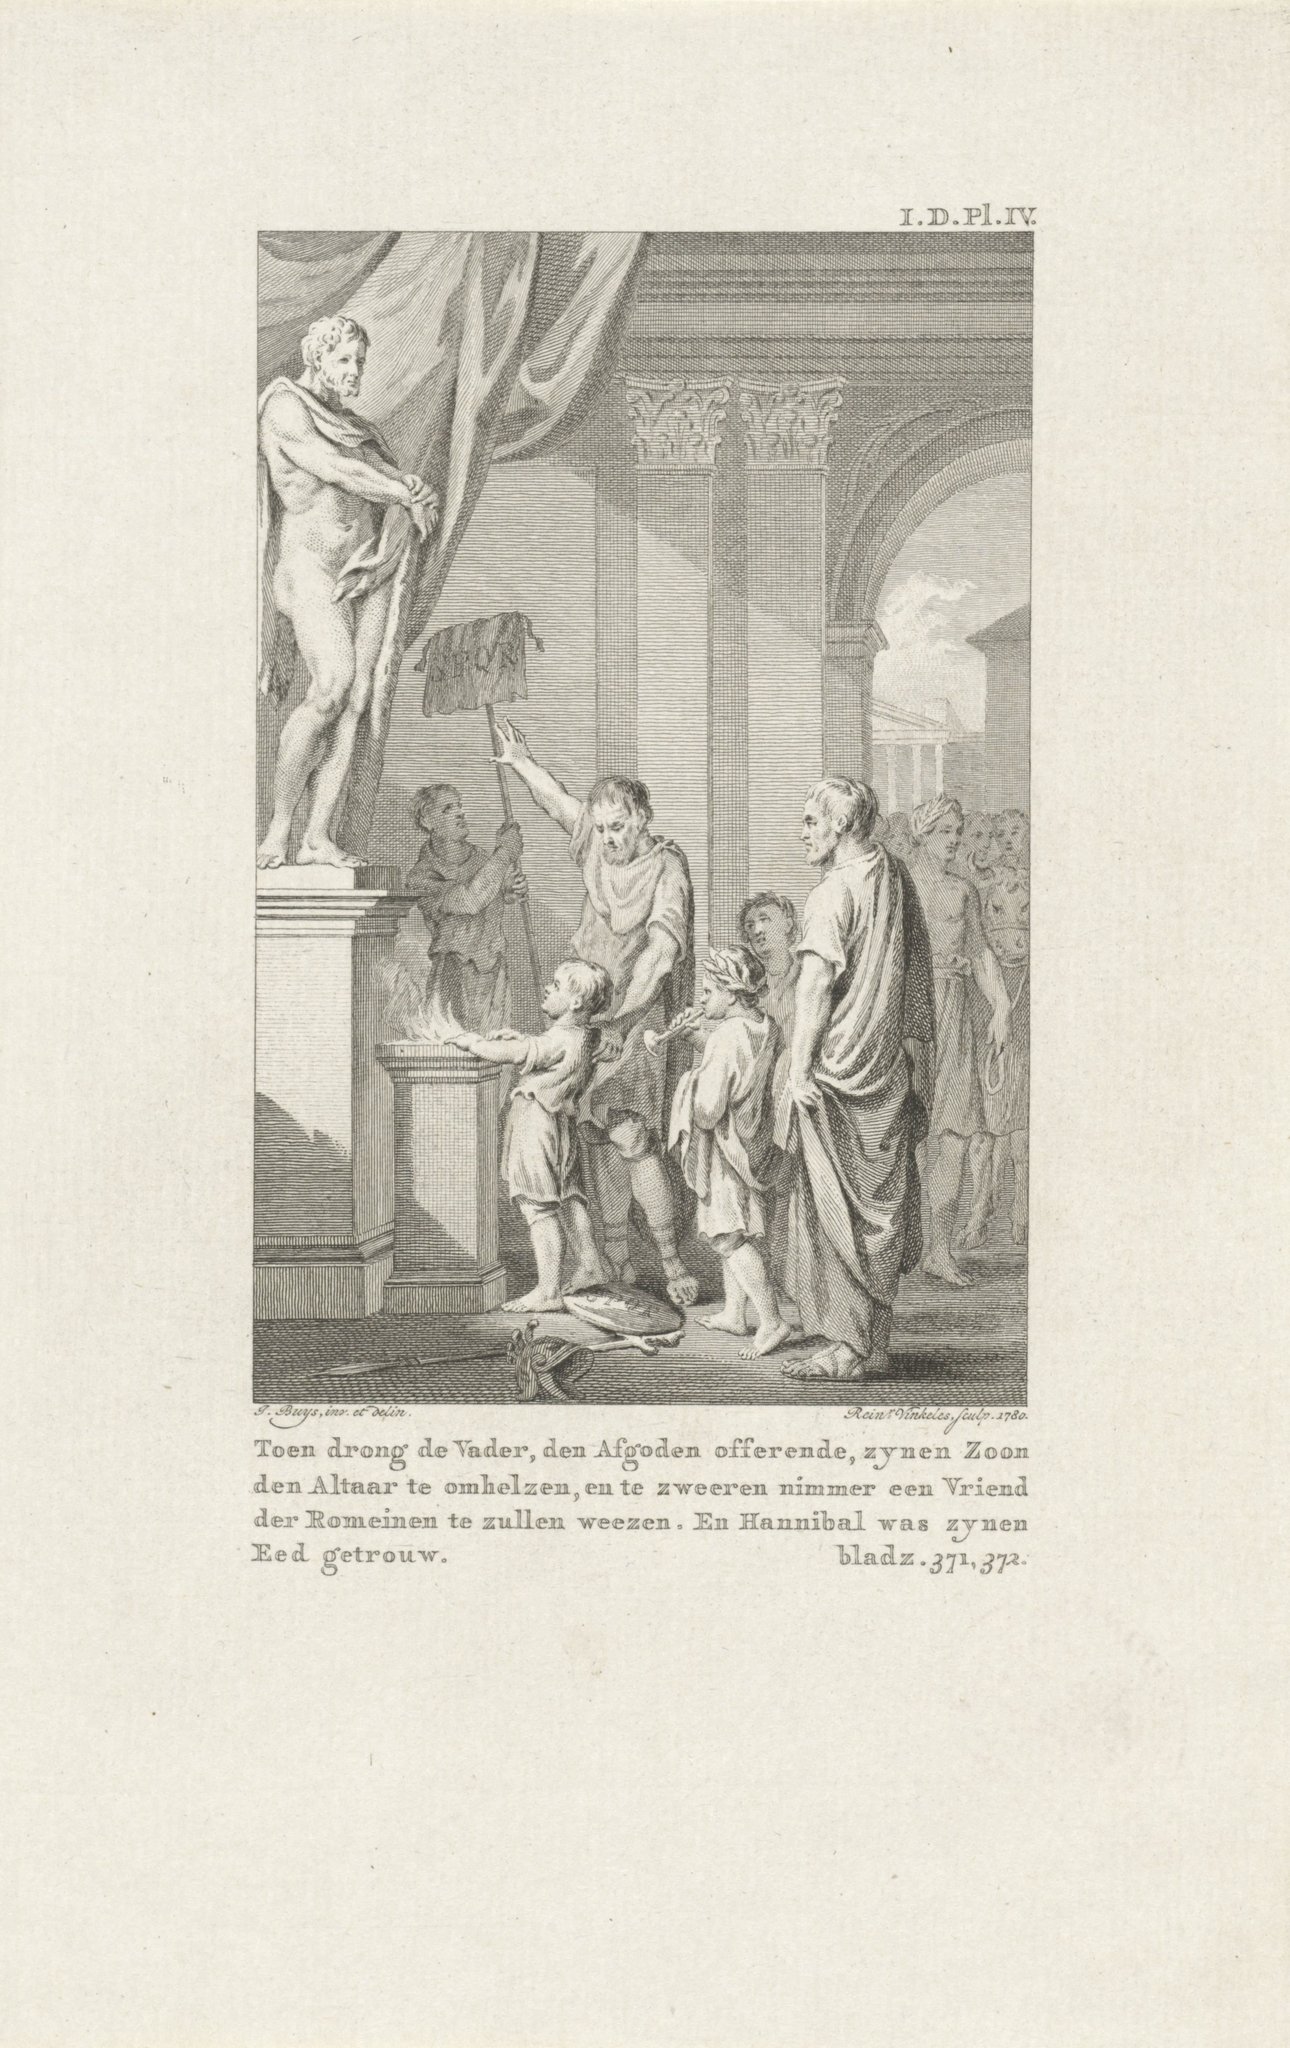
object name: print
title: Toen drong de Vader, den Afgoden offerende (...)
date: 1780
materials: paper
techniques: engraving, etching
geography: amsterdam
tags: swearing allegiance to a ruler (+ variant), altar ~ non-christian religions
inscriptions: collector's mark: Lugt 240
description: Het kind Hannibal zweert tegen de Romeinen, bij een altaar met een klassiek beeld. Naast hem zijn vader Hamilcar Barkas. Rechtsboven: I.D.Pl.IV. Rechtsonder: bladz.371-372.